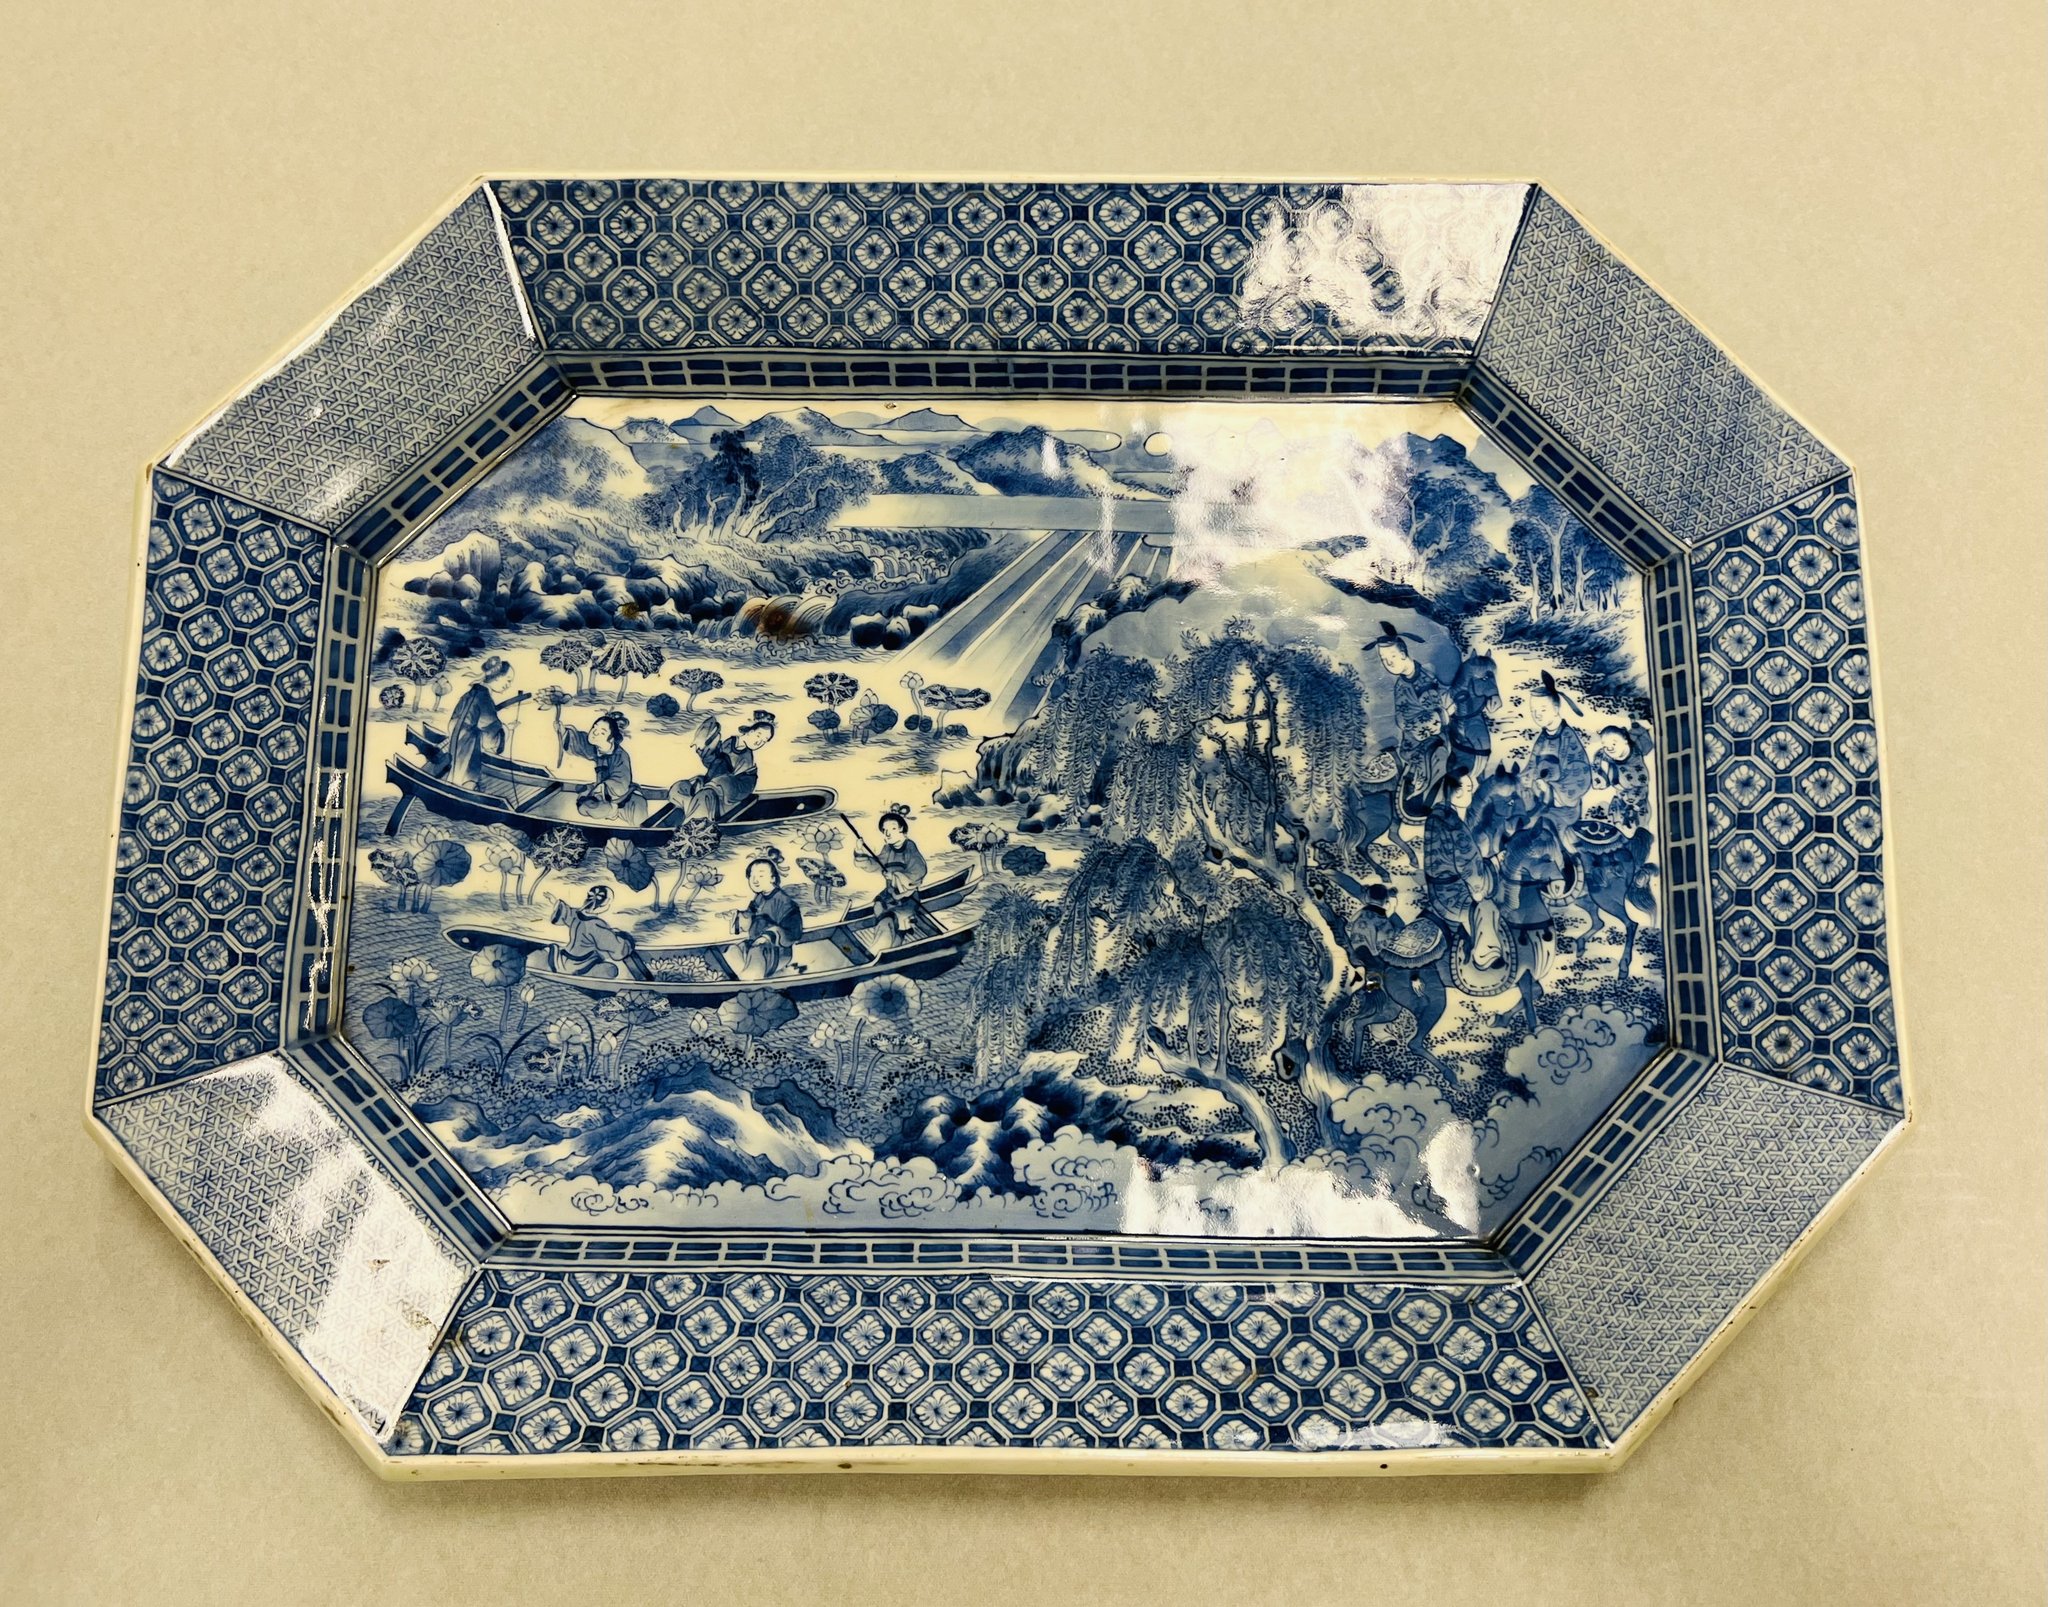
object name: plate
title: Large Octagonal Plate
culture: japanese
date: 1830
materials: glaze, porcelain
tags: human figures,trees,boats